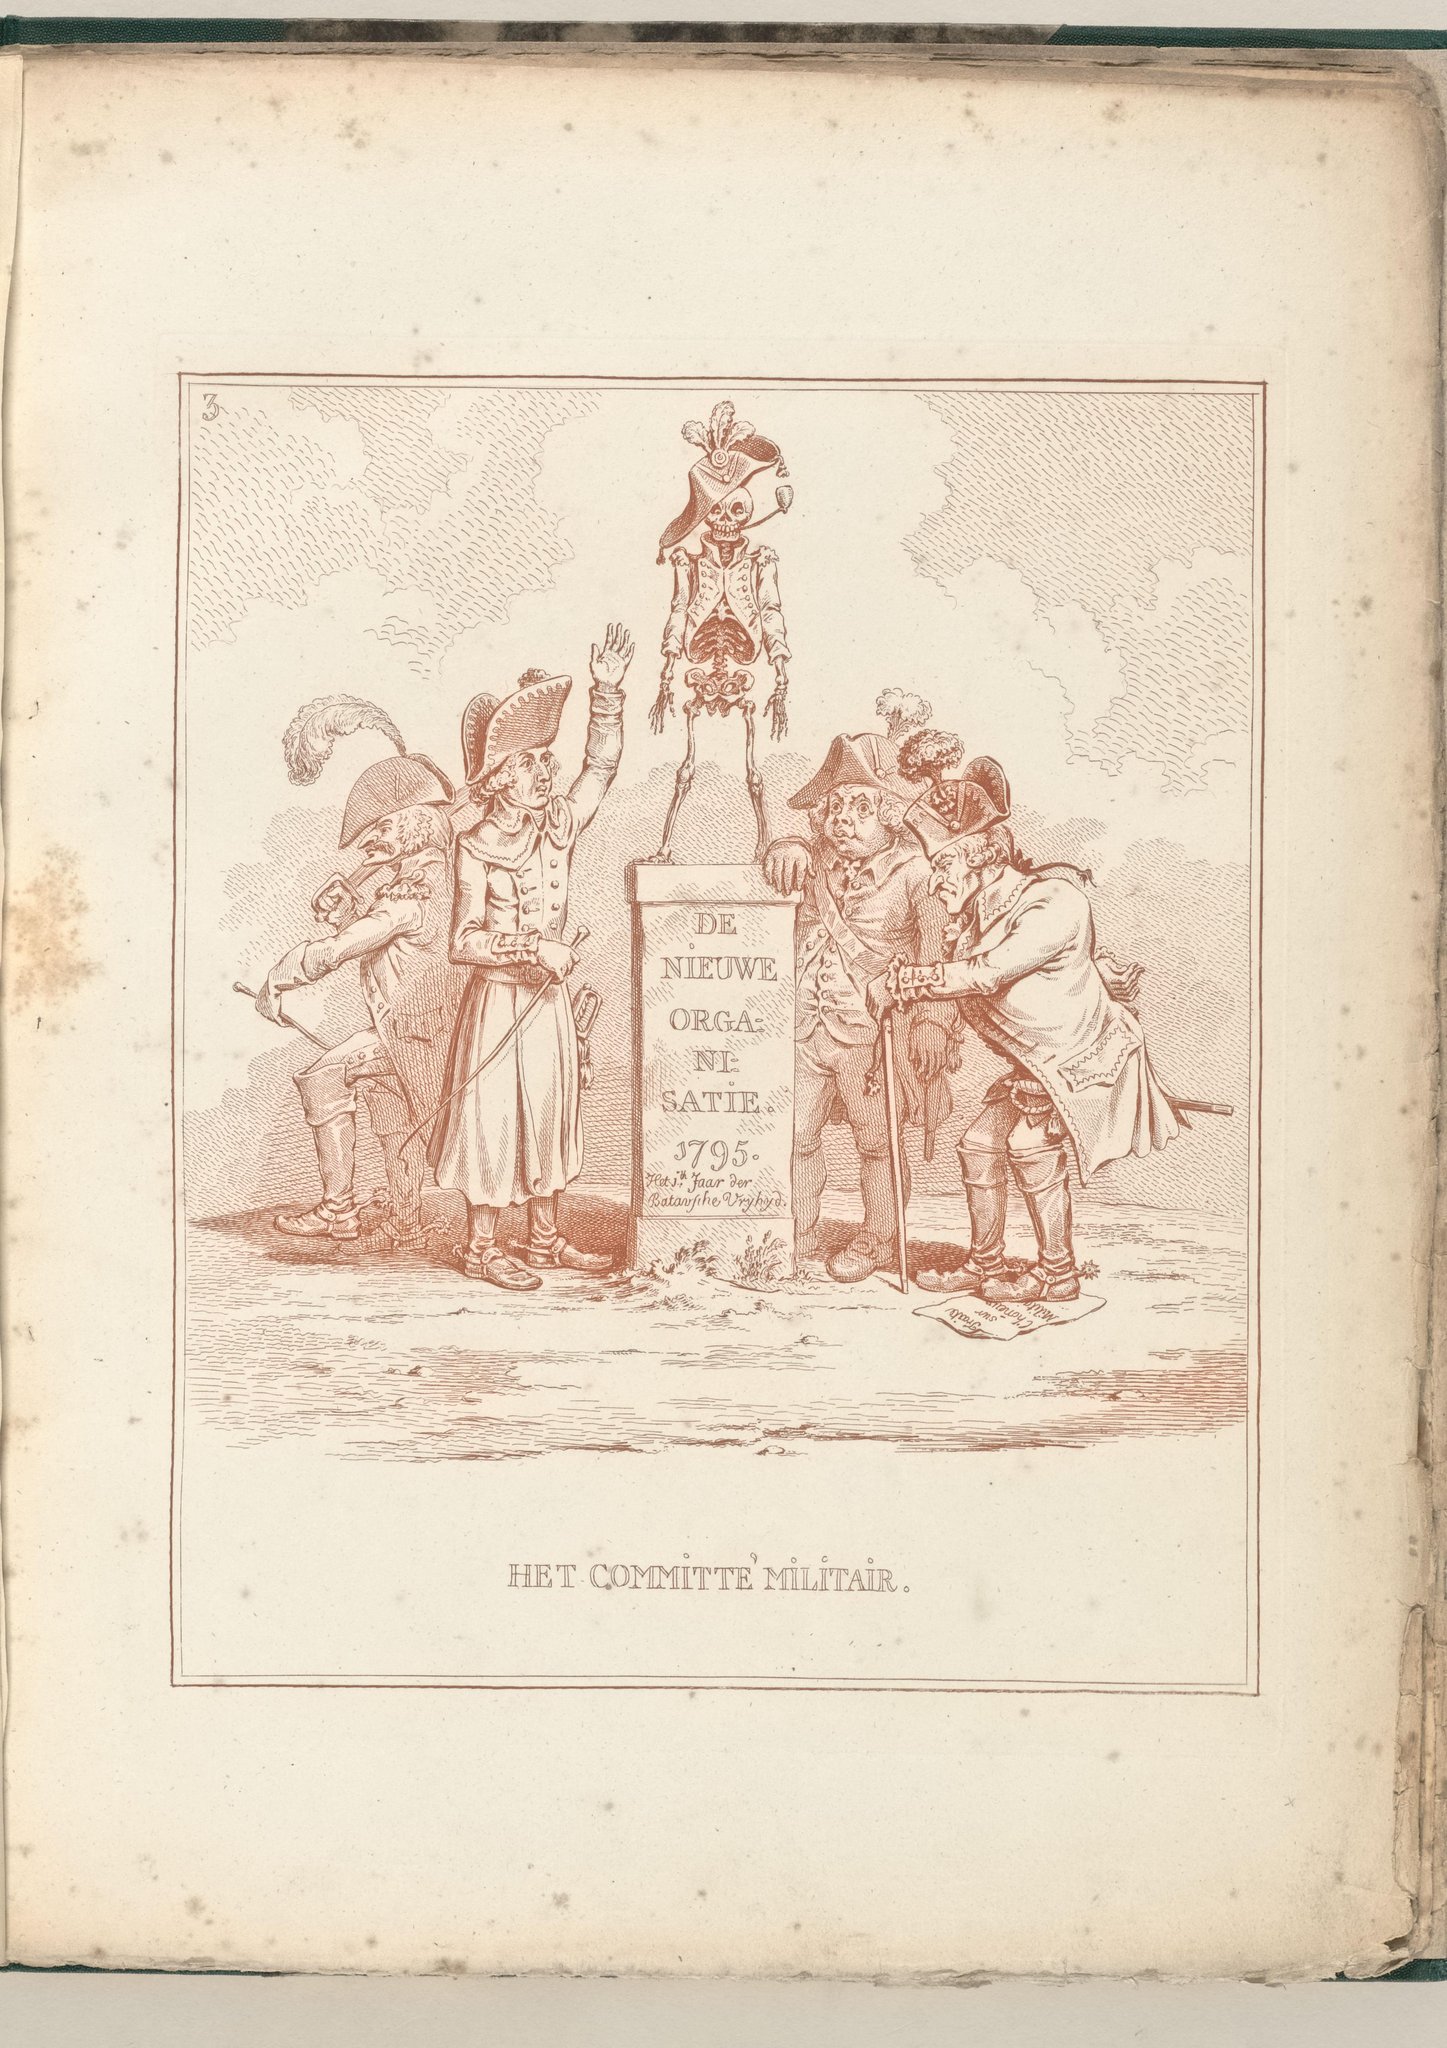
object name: print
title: Het Committé Militair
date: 1795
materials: paper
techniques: etching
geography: london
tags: herman willem daendels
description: Onderdeel van een in boekvorm uitgegeven serie van twintig spotprenten op de Provisionele Representanten van het Volk van Holland en de Bataafse Republiek in het algemeen in het jaar 1795. De serietitel 'Hollandia Regenerata' staat vermeld op de titelprent. Elke prent gevolgd door een tekstblad met een Bijbelcitaat in het Nederlands, een verklaring in het Frans en het Bijbelcitaat in het Engels. Waarschijnlijk uitgegeven in Londen door William Humphrey in 1795.